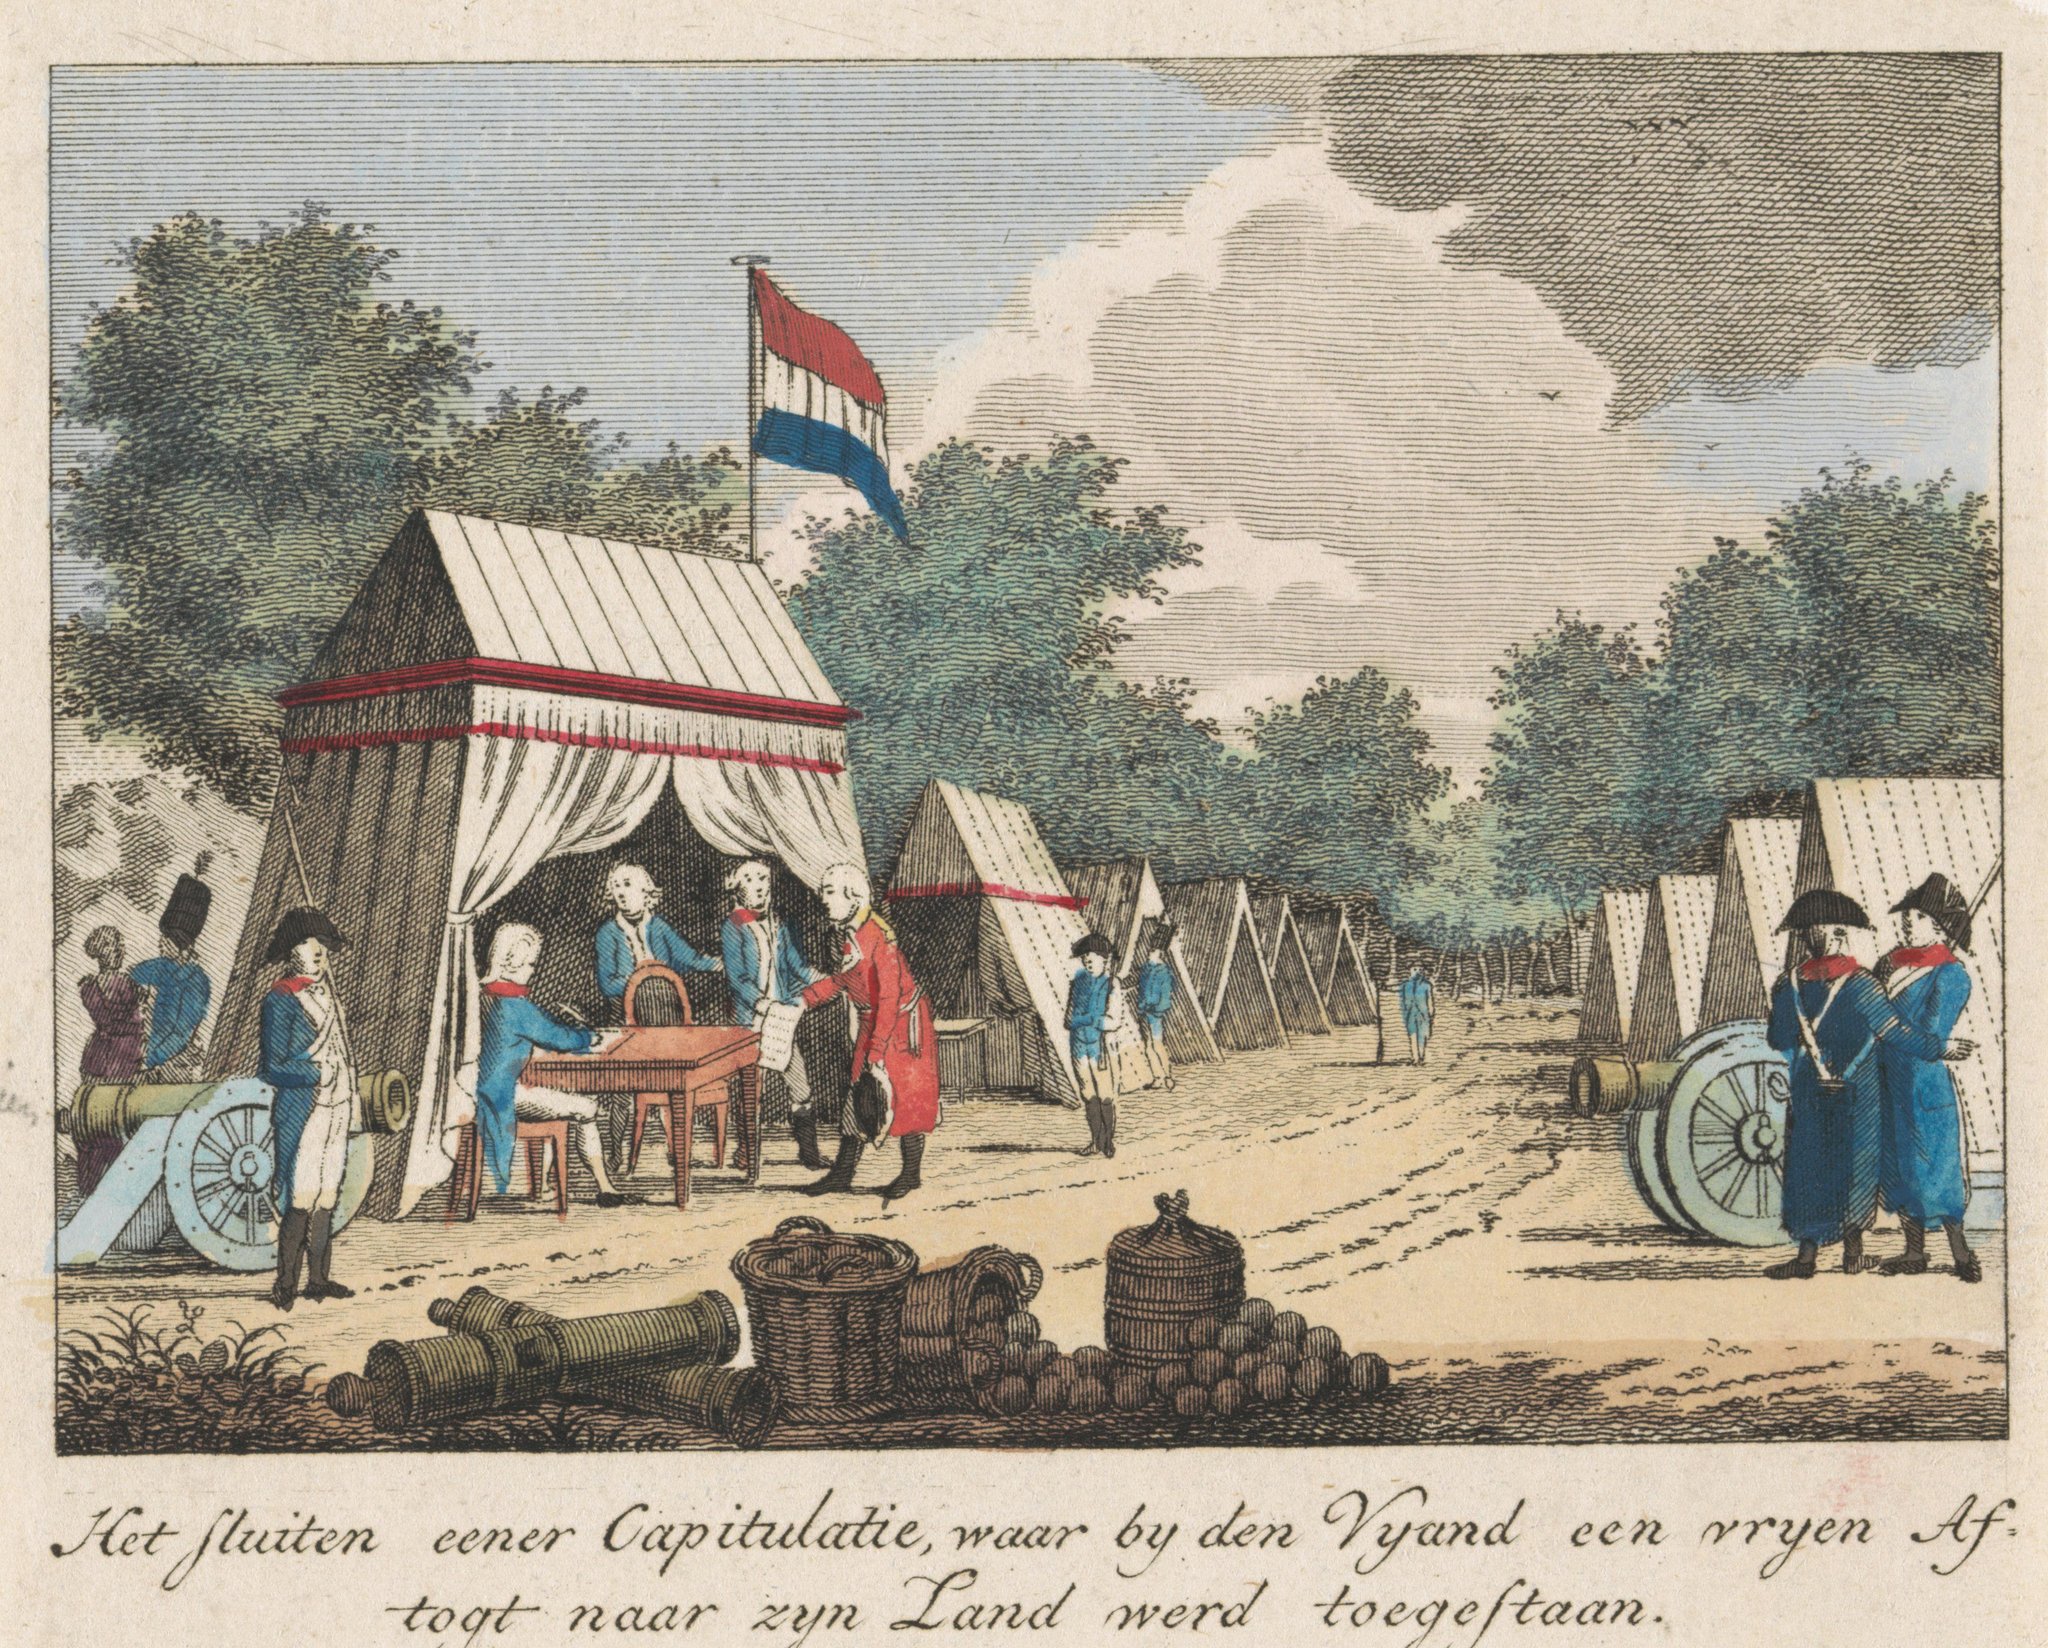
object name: print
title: Het sluiten eener Capitulatie, waar by den Vyand een vryen Aftogt naar zyn Land werd toegestaan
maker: Anonymous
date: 1800-1805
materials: paper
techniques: etching, hand coloring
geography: netherlands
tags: signing of peace treaty, concluding the peace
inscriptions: collector's mark: Lugt 2228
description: In een legertent wordt een wapenstilstand gesloten tussen enerzijds het Frans-Bataafse leger en anderzijds het Brits-Russische leger. In werkelijkheid vonden de vredesonderhandelingen plaats in het hoofdkwartier van Brune te Alkmaar. De Conventie van Alkmaar werd gesloten op 10 oktober 1799.